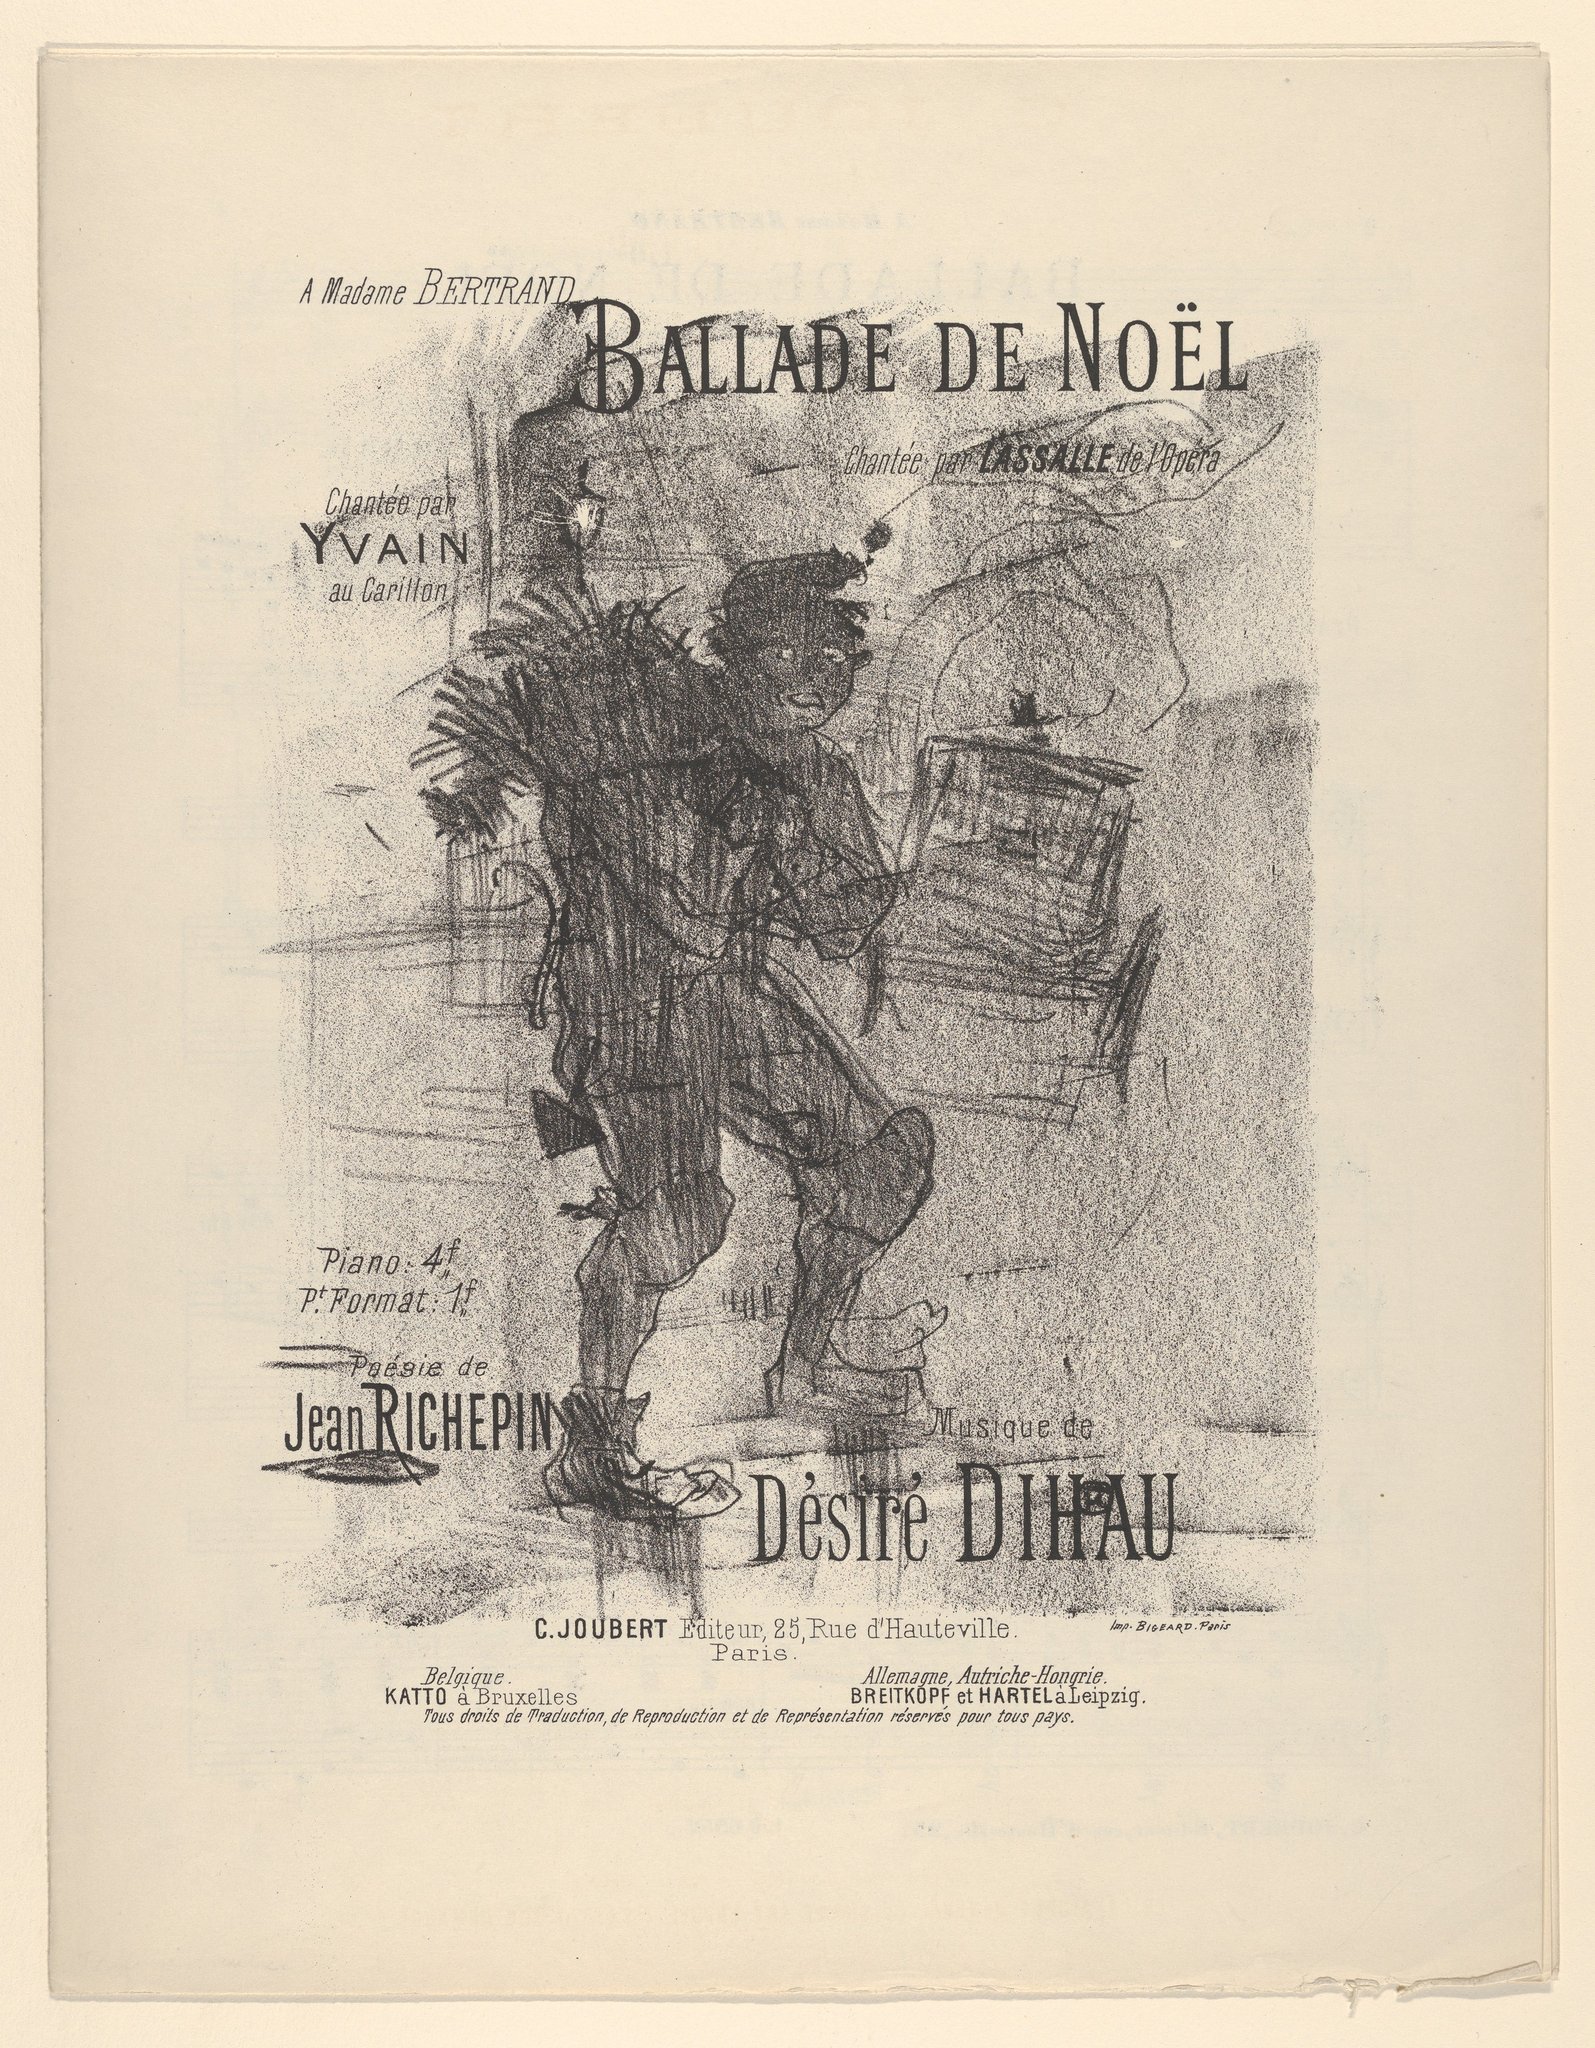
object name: print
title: Ballade de Noël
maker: henri de toulouse-lautrec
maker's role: artist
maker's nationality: french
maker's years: 1864-1901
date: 1895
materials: crayon, paper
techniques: lithograph, printing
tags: human figures